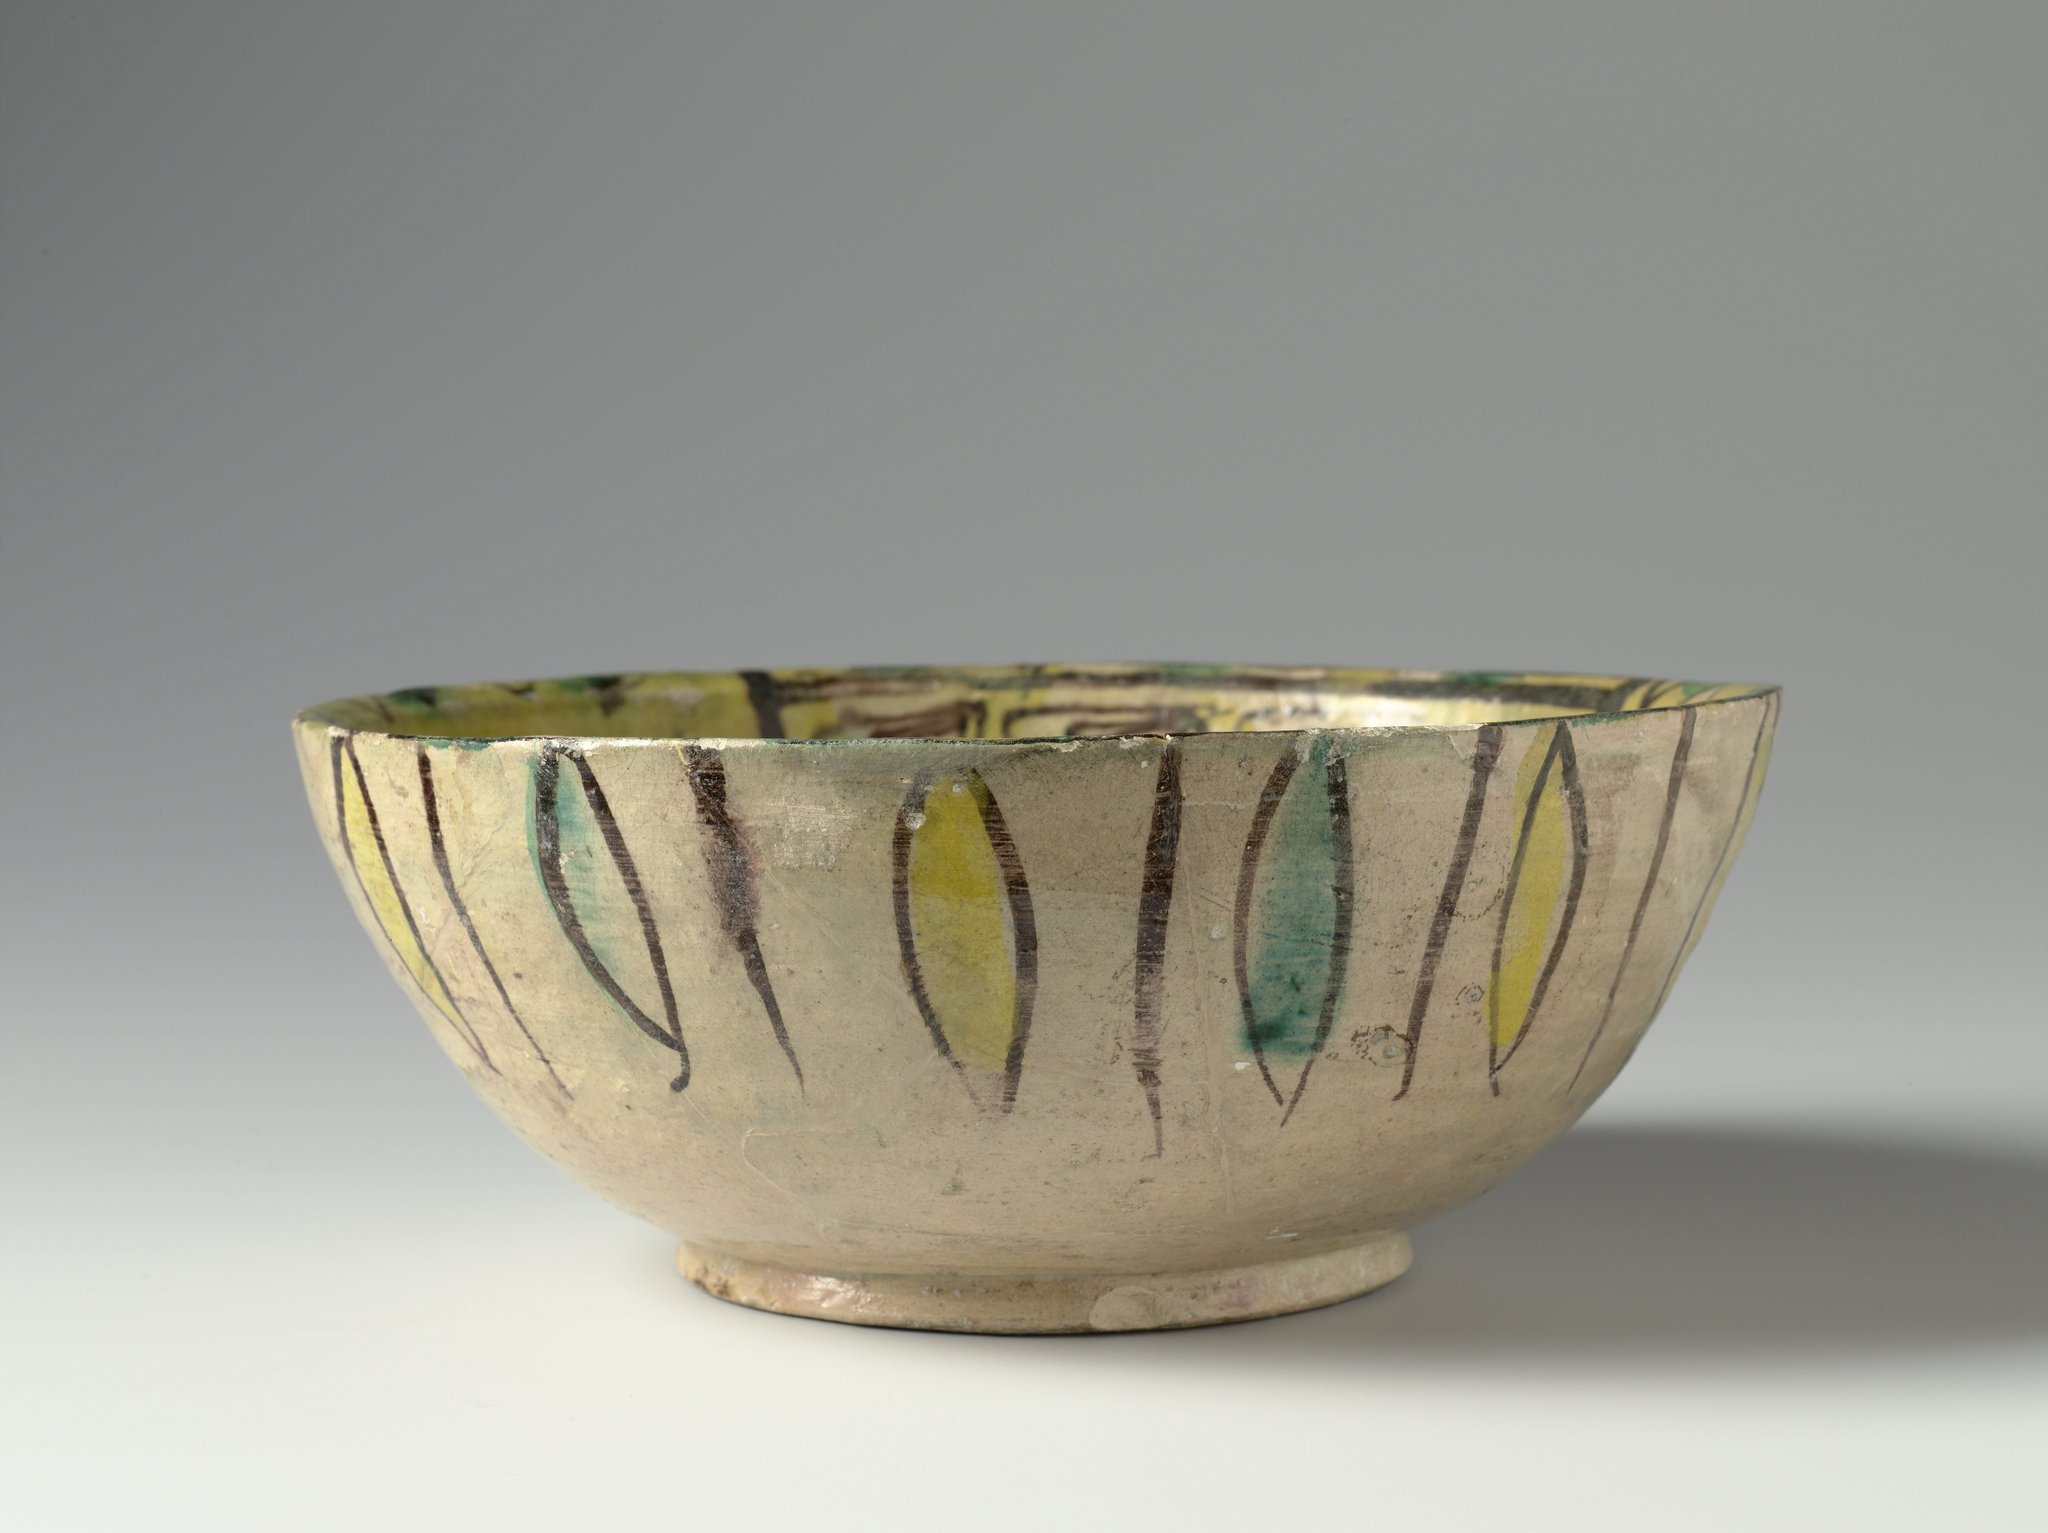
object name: bowl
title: Bowl with deer and ornaments in yellow, green and brown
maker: Anonymous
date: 900-999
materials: earthenware, glaze, paint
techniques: firing, turning, vitrification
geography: nishapur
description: Kom van aardewerk gedecoreerd met mangaanbruine slib naast groene en gele loodglazuren op een engobe van cremekleurige slib. De binnenzijde is verdeeld in vier vakken met afwisselend een gestileerd hert en een cartouche met daarboven een band met schrift. De buitenwand is verdeeld in vakken met een gekleurd ovaal.